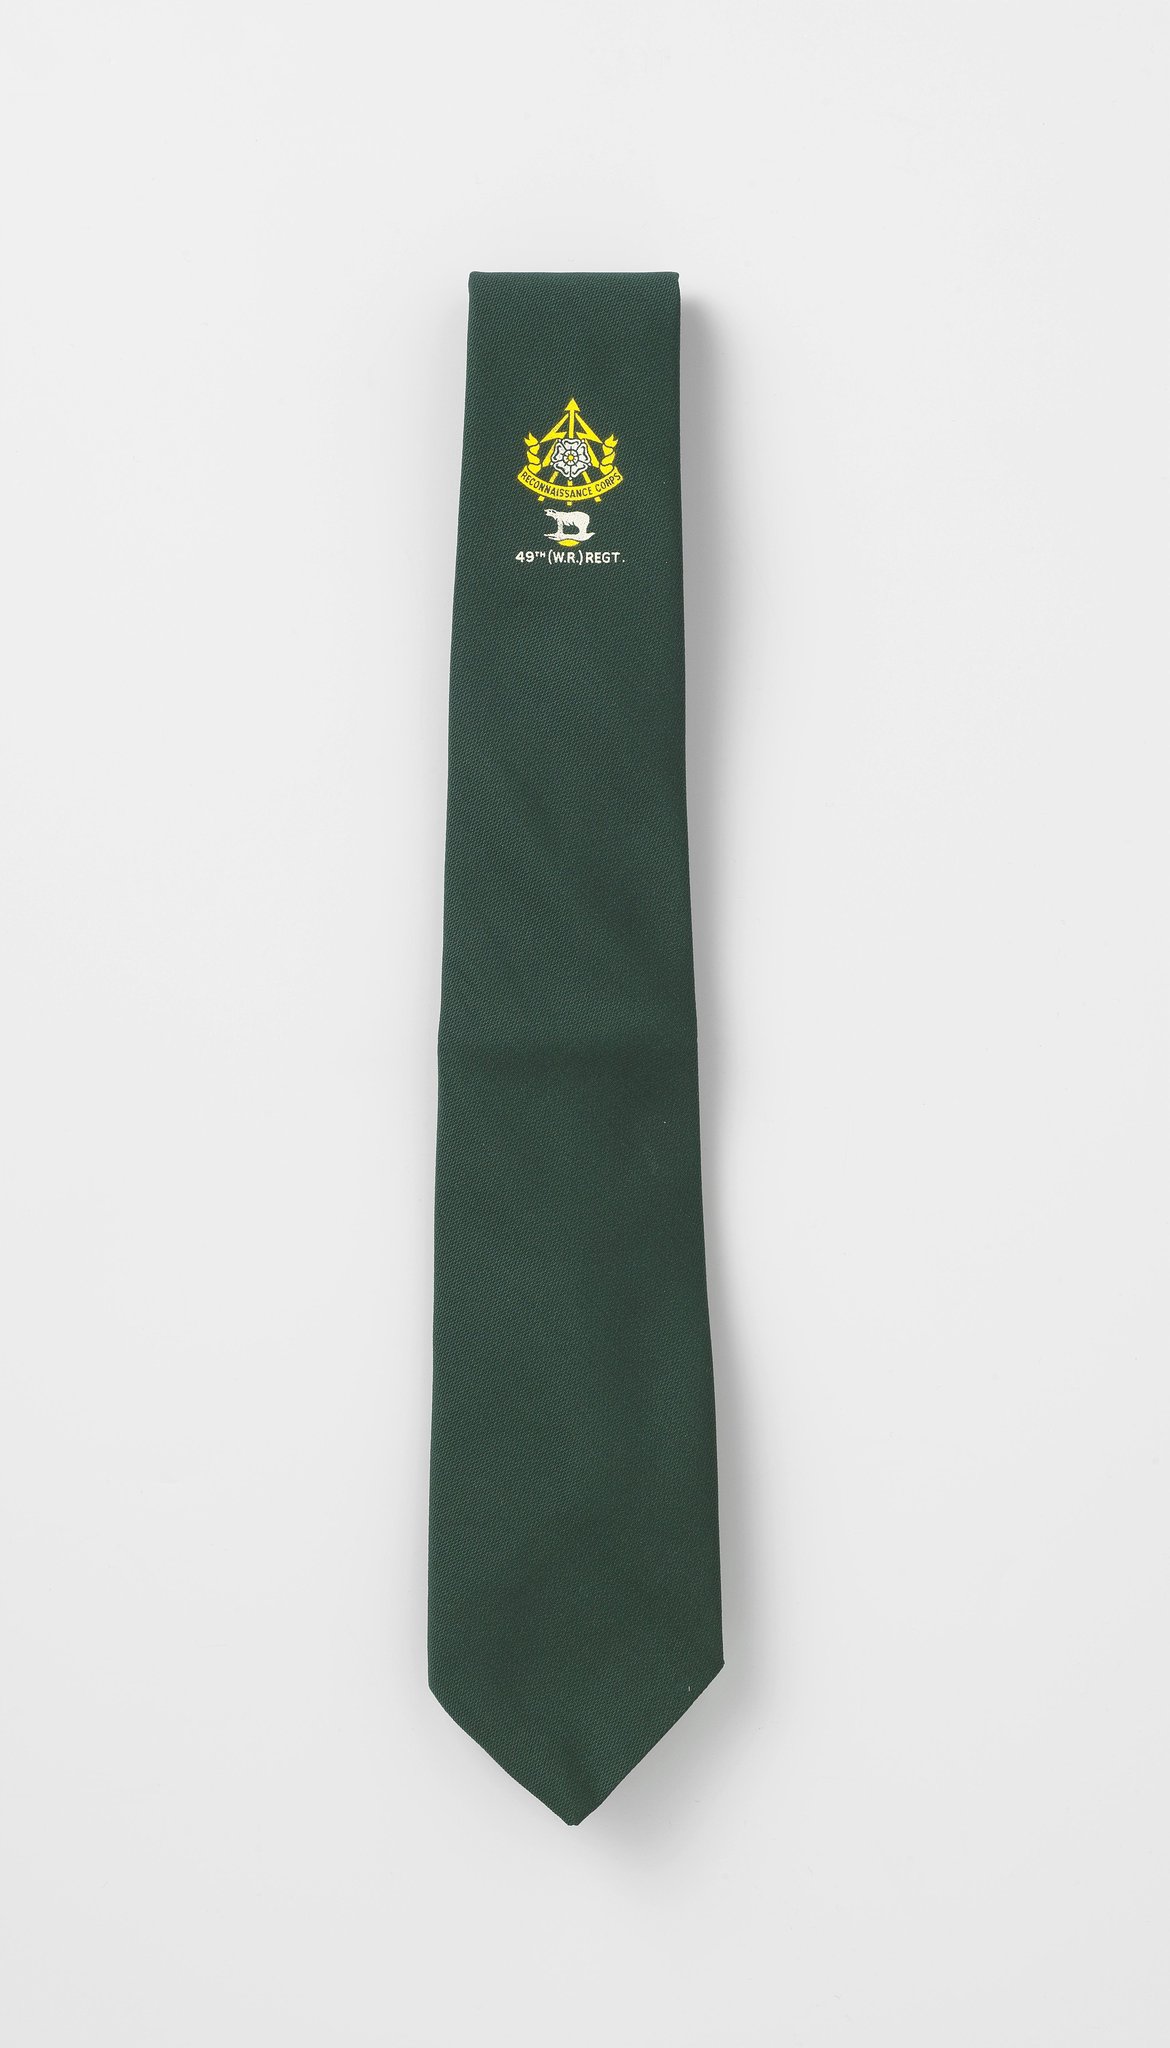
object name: neckcloth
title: Britse das van de British Army's 49th regiment reconaissance Corps, de 'Polar Bear Division' van Tonny van Rentherghem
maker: Anonymous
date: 1990-1995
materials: textile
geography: england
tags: amsterdam, tonny van renterghem, netherlands, england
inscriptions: inscription: ‘RECONAISSANCE CORPS 49TH (W.R.) REGT.’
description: Donkergroene das met geel embleem waarin witte bloem. Hieronder ijsbeer en opschrift. Het 49th Regiment bevrijdde o.a Amsterdam. Van Renterghem werd erelid gemaakt in 1995 nadat hij ze in dat jaar in Amsterdam had verwelkomt als bevrijders.